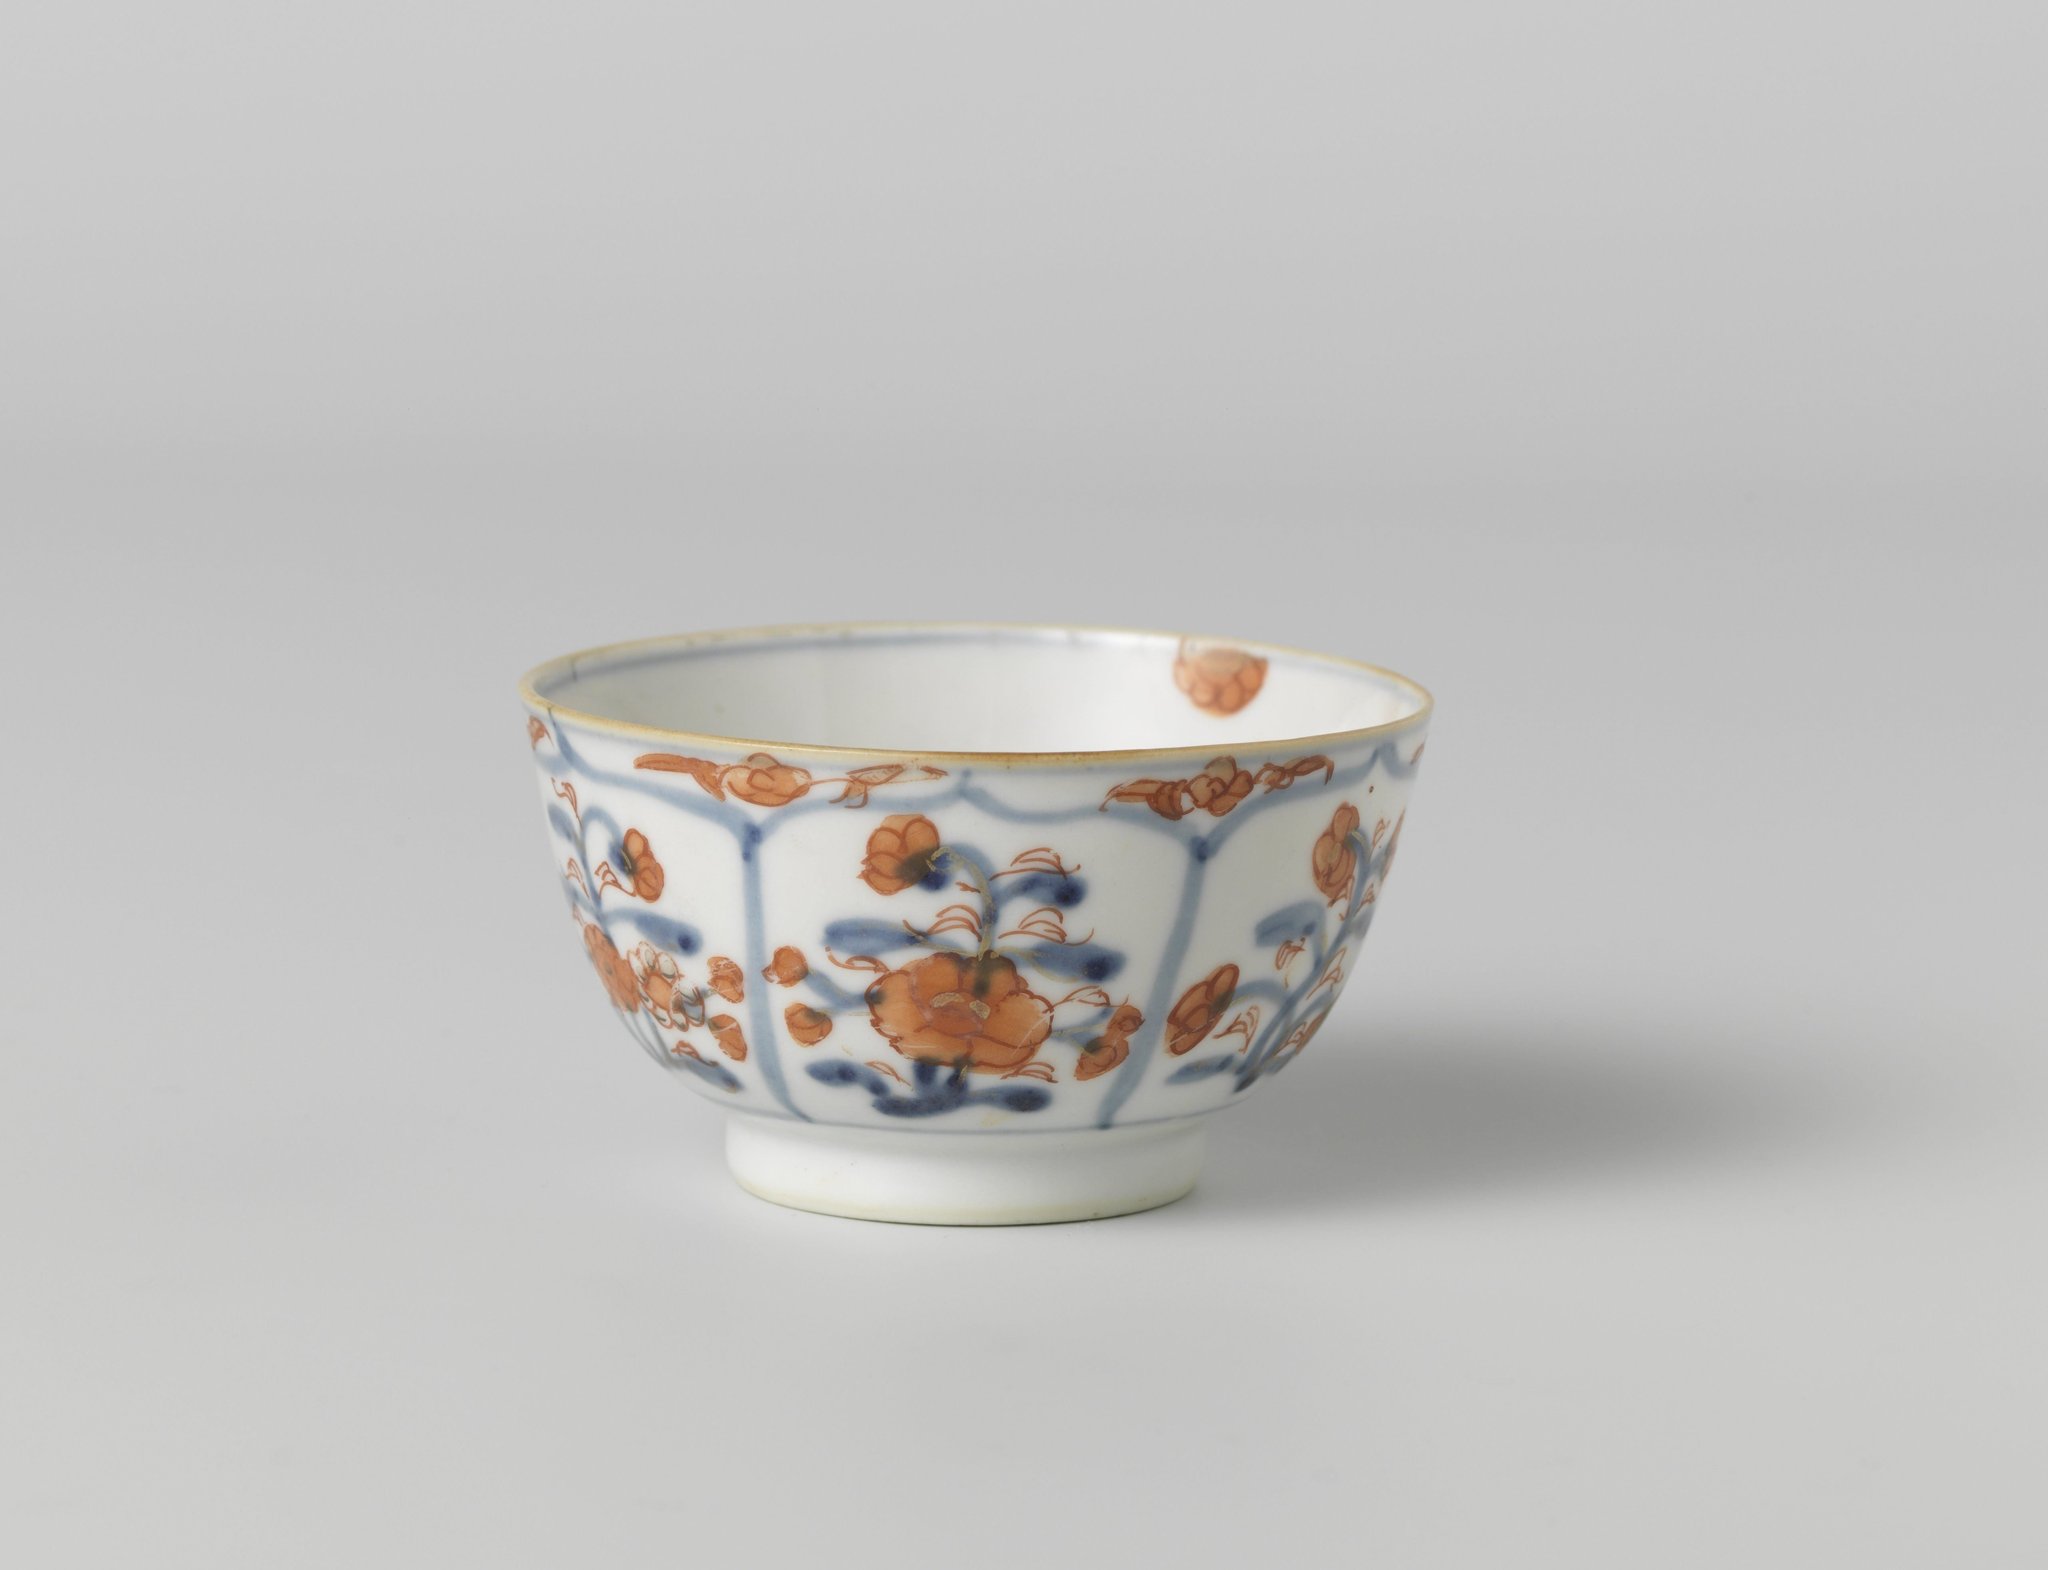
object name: cup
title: Cup with petal-shaped panel around a central medallion, filled with flower sprays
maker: Anonymous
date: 1750-1774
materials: cobalt, glaze, gold, paint, porcelain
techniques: firing, gilding, turning, vitrification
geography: china